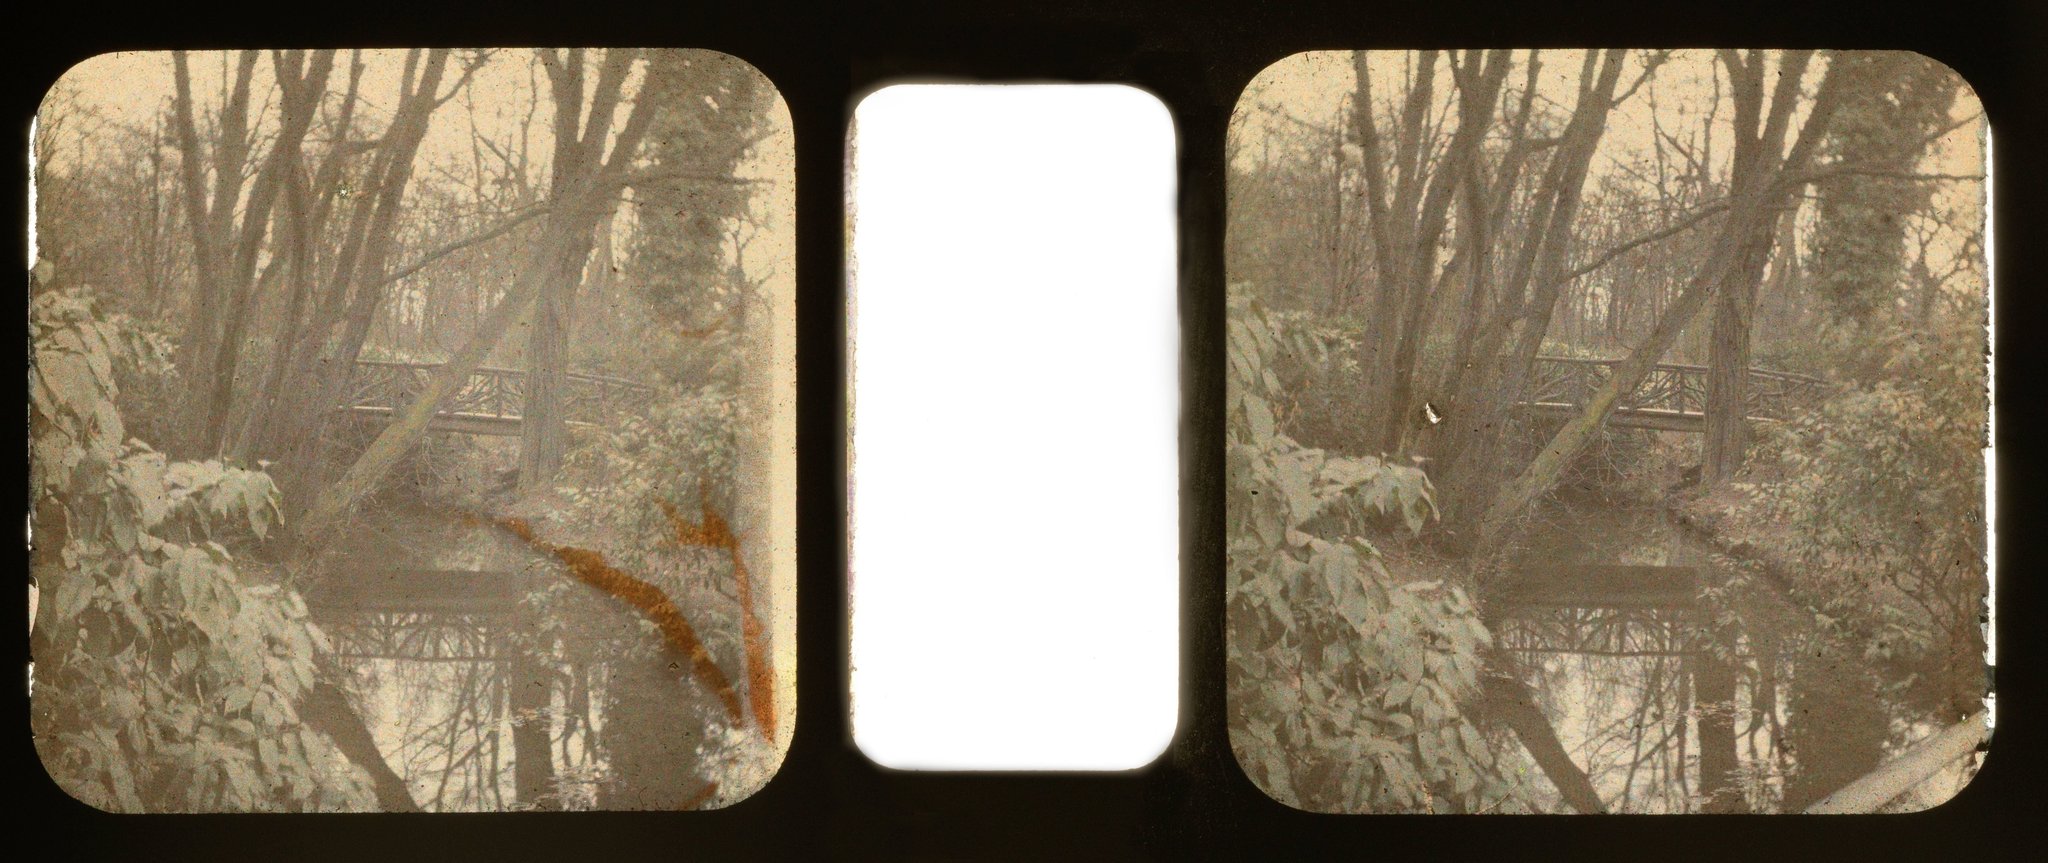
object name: stereoscopic photograph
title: Brug in een bos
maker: adolphe burdet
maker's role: fotograaf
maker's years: 1860-1940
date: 1907-1935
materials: glass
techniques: autochrome process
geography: netherlands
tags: forest, wood, bridge, netherlands